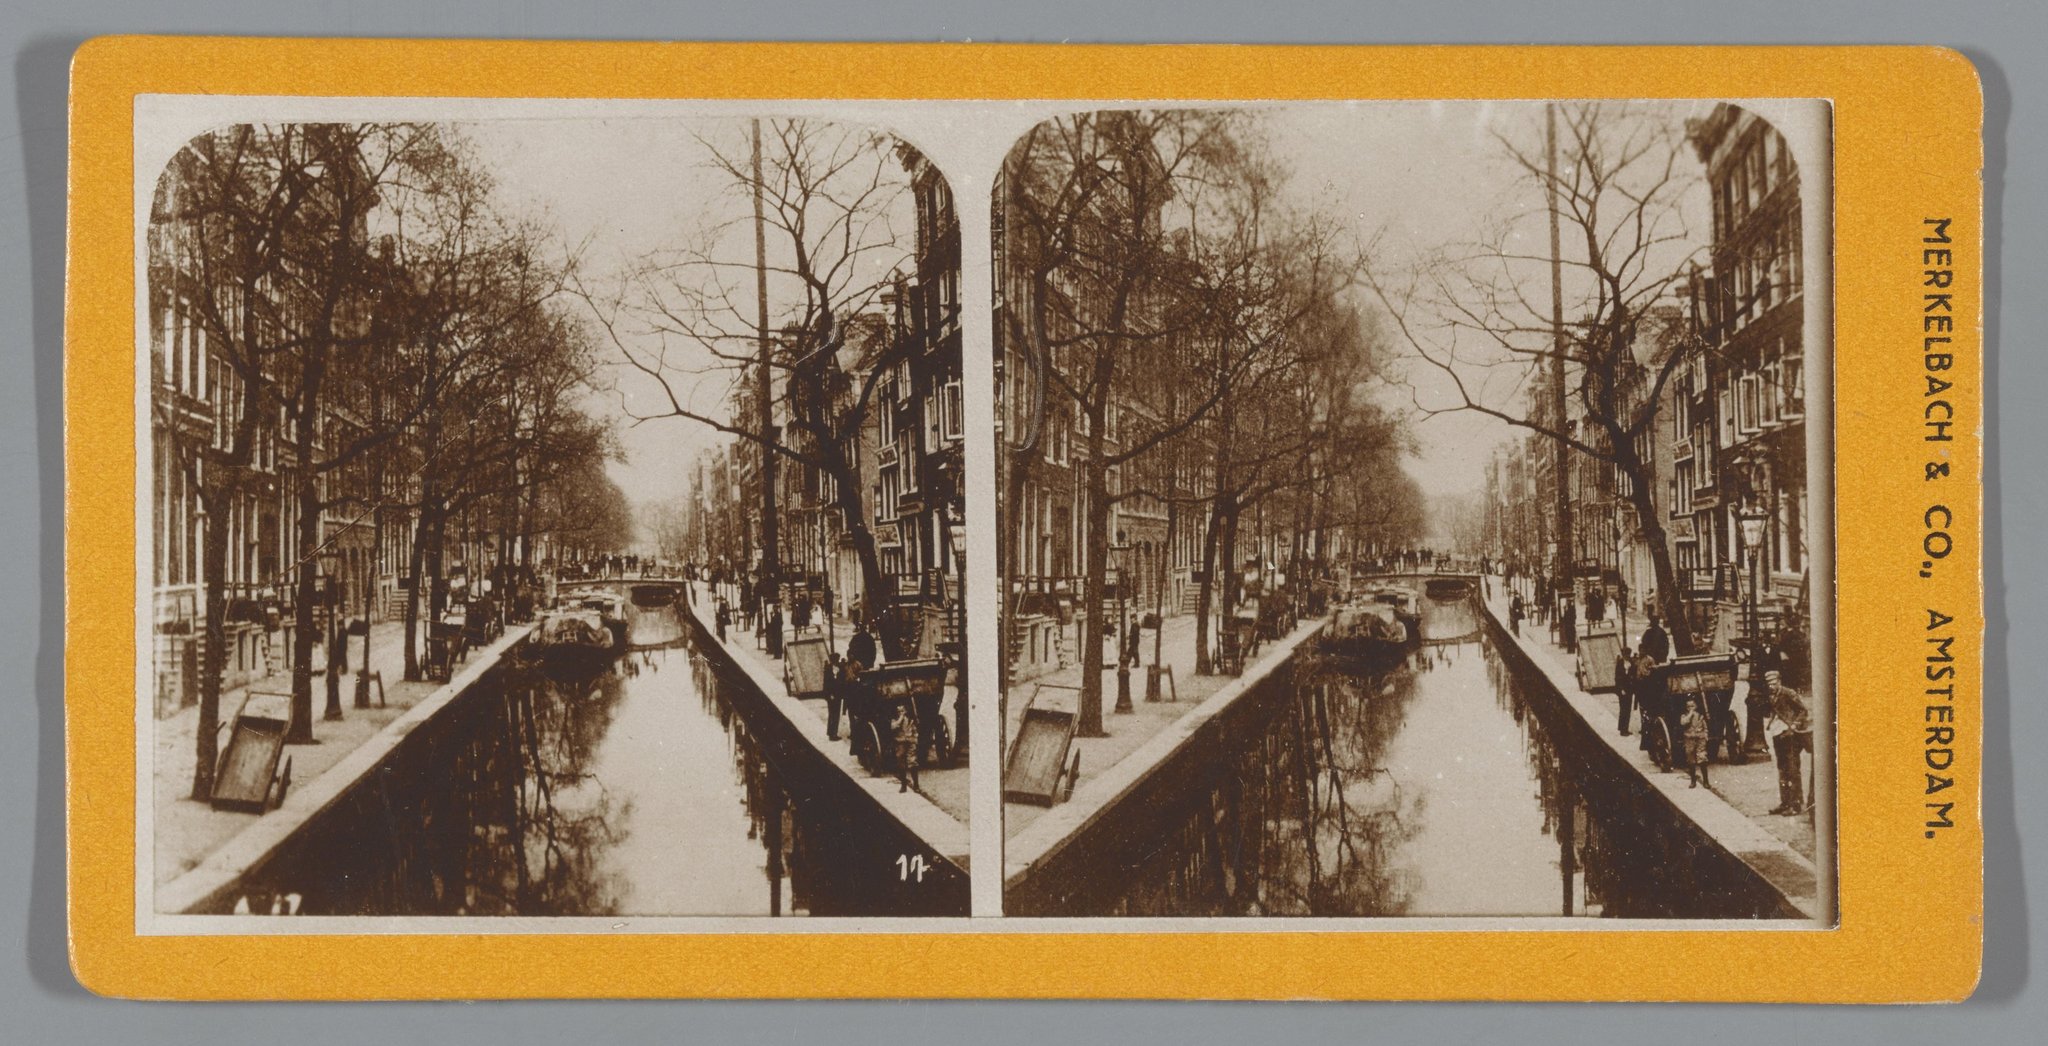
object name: stereograph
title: Collectie A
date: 1900-1902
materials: paper, cardboard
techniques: collodion silver print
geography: amsterdam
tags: canals, waters (in city)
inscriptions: number: ‘17’, number: ‘17’, inscription: ‘nl. de Oudezijds Achterburgwal (...) "sluis" (brug).’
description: Fotografische heruitgave van oorspronkelijke stereokaart.